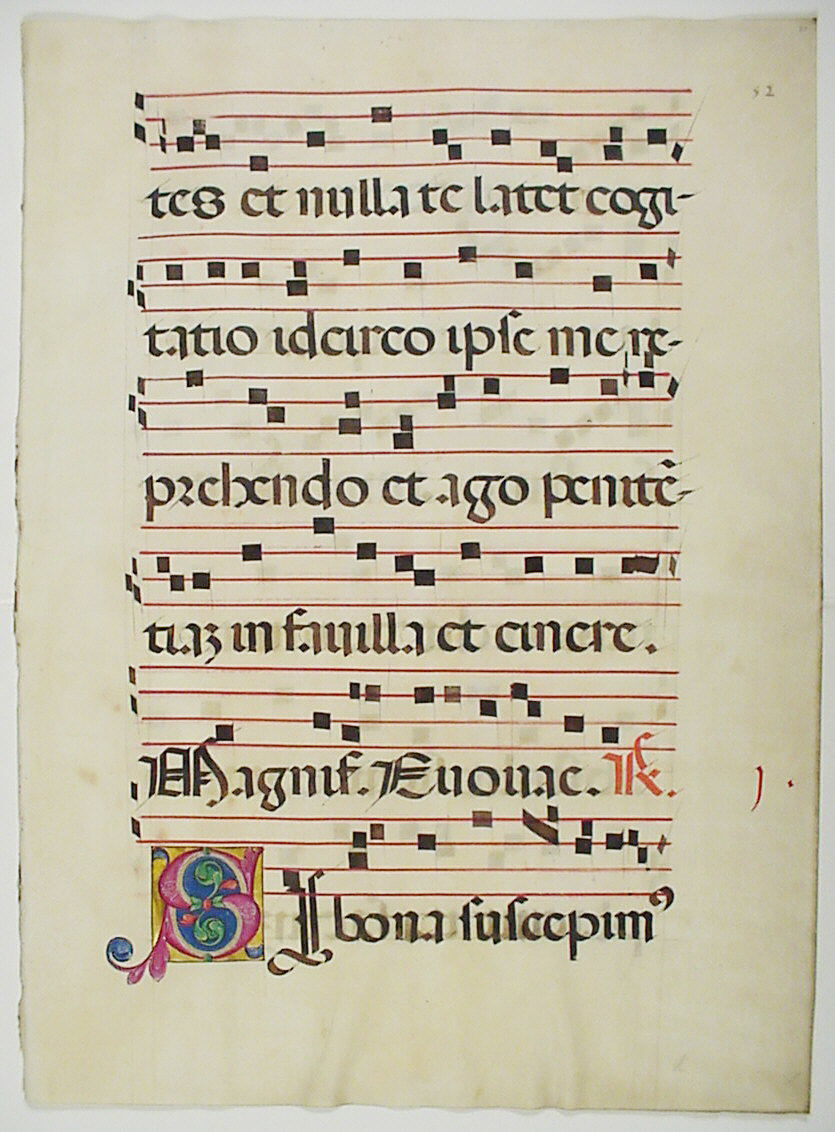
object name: choir book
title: Manuscript Leaf with Initial S, from a Choir Book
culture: italian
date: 1401-1500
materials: ink, metal leaf, parchment, paint